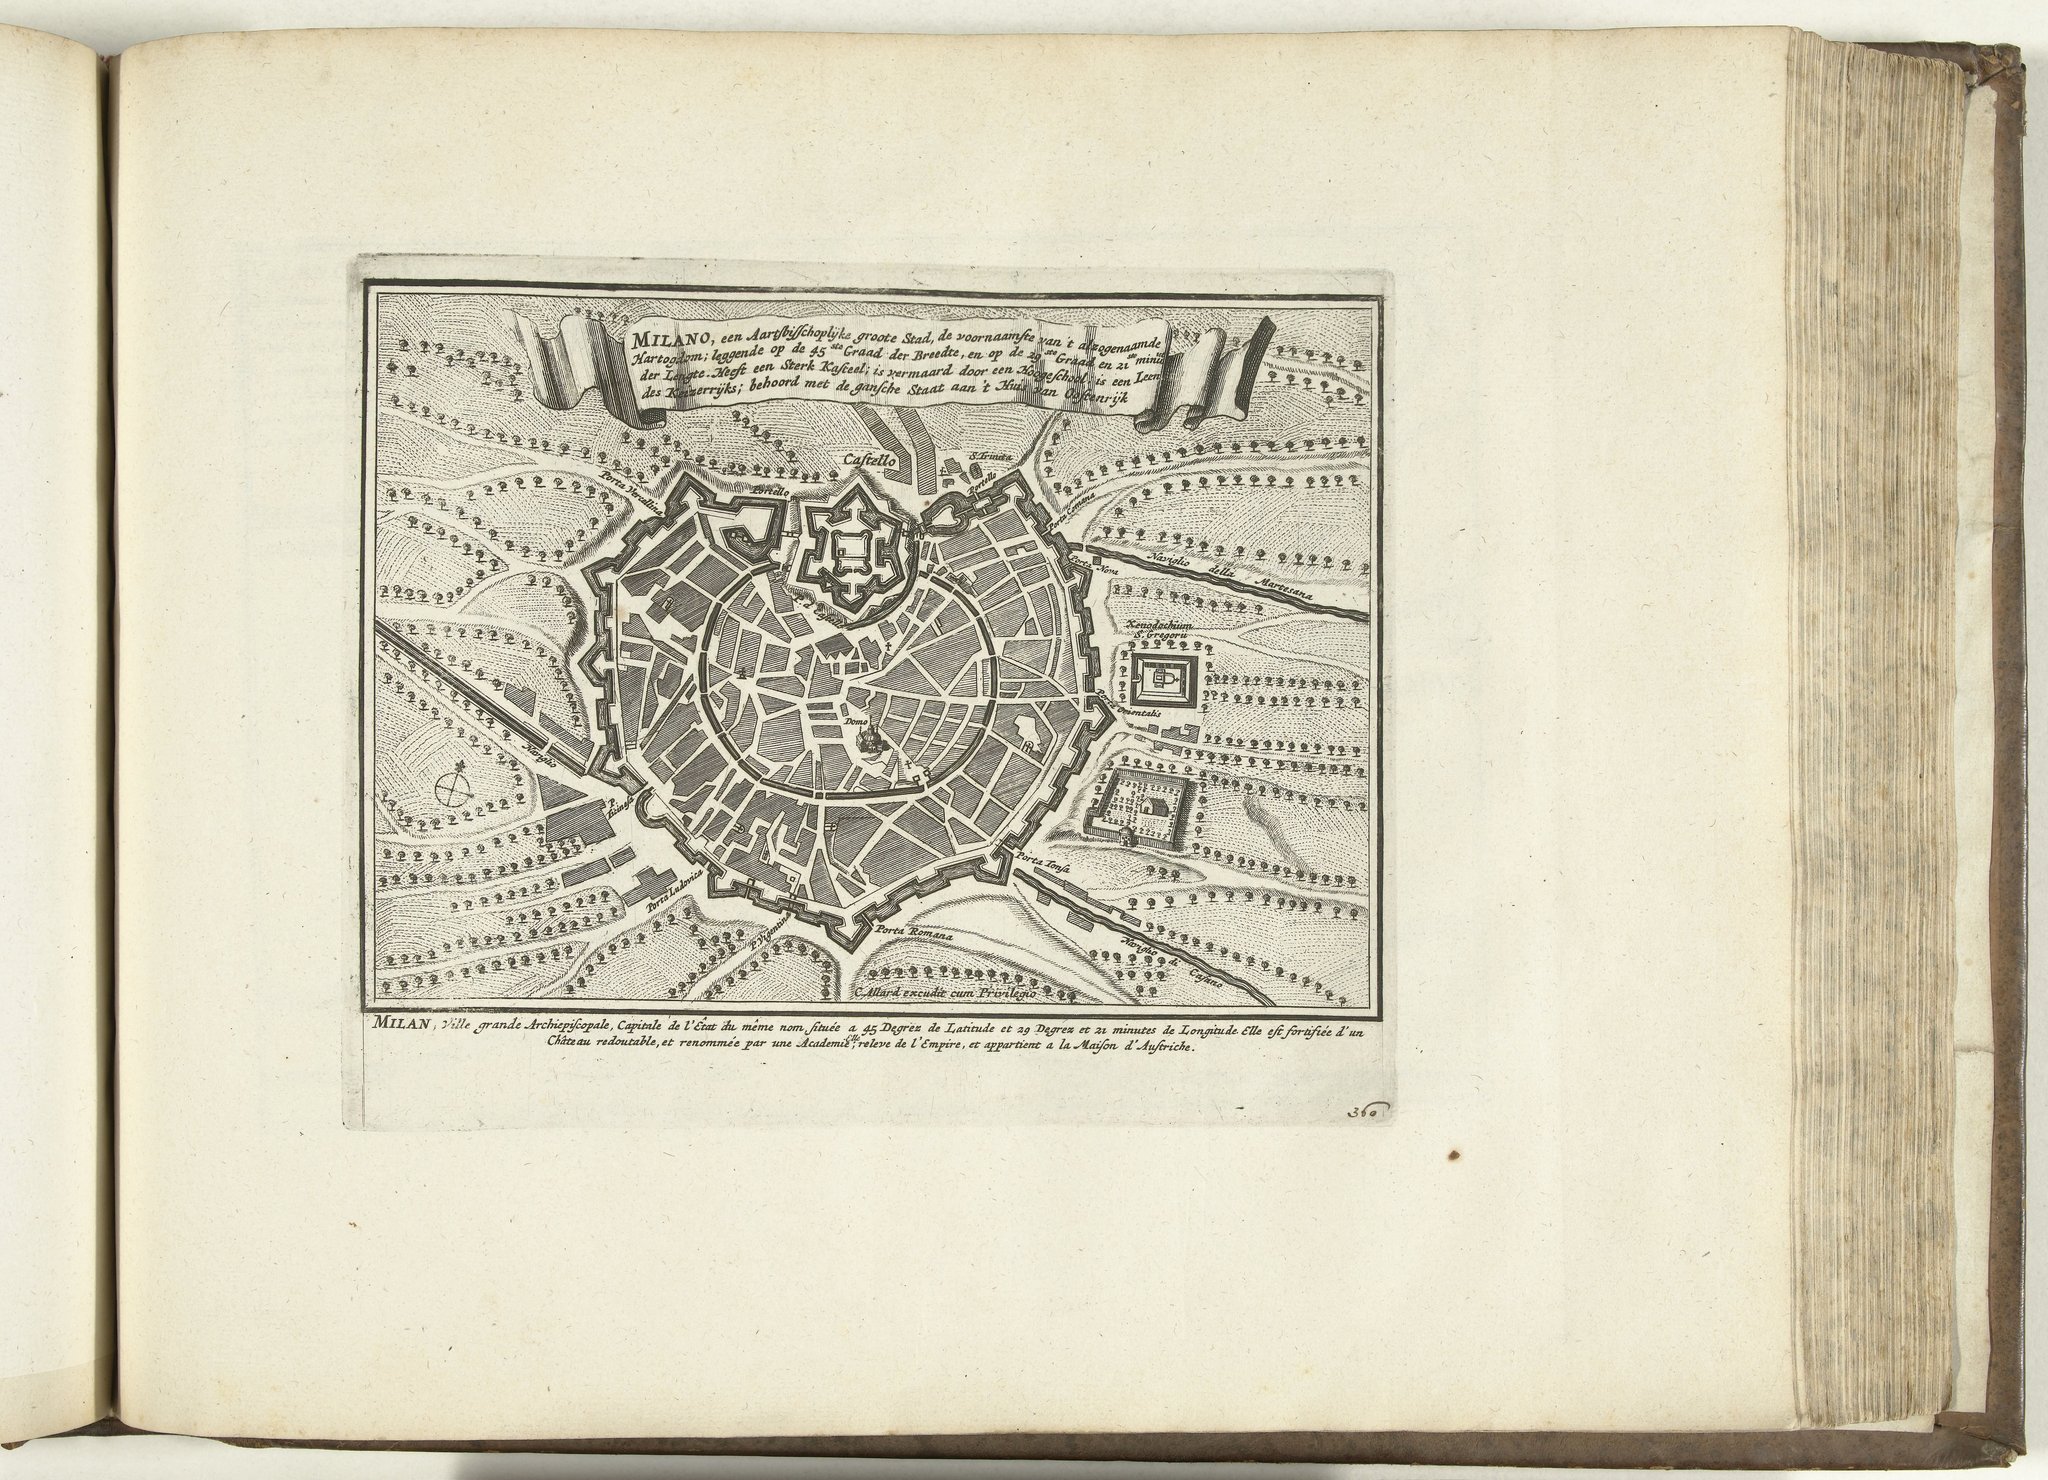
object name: print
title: Plattegrond van Milaan, 1726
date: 1726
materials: paper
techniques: etching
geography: leiden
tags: fortress, maps of cities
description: Plattegrond van de versterkingen om de Italiaanse stad Milaan. Plaat nr. 360 in deel XV van het prentwerk: Les Forces de l'Europe, Asie, Afrique et Amerique ... Comme aussi les Cartes des Côtes de France et d'Espagne uit 1726, dit tweede deel met 271 met de hand genummerde platen van vermaarde sterke steden en vestingen in het kader van de Spaanse Successieoorlog 1701-1713. Voor het merendeel zijn deze platen gekopieerd naar de anonieme Franse platen van vermaarde sterke steden en vestingen: in Les forces de l'Europe en in: Le theatre de la guerre, dans les Pays-Bas, beide oorspronkelijk uitgegeven door Nicolas de Fer te Parijs (1693-1697) in het kader van de Negenjarige Oorlog. Titels in het Nederlands en Frans, opschriften in het Italiaans.